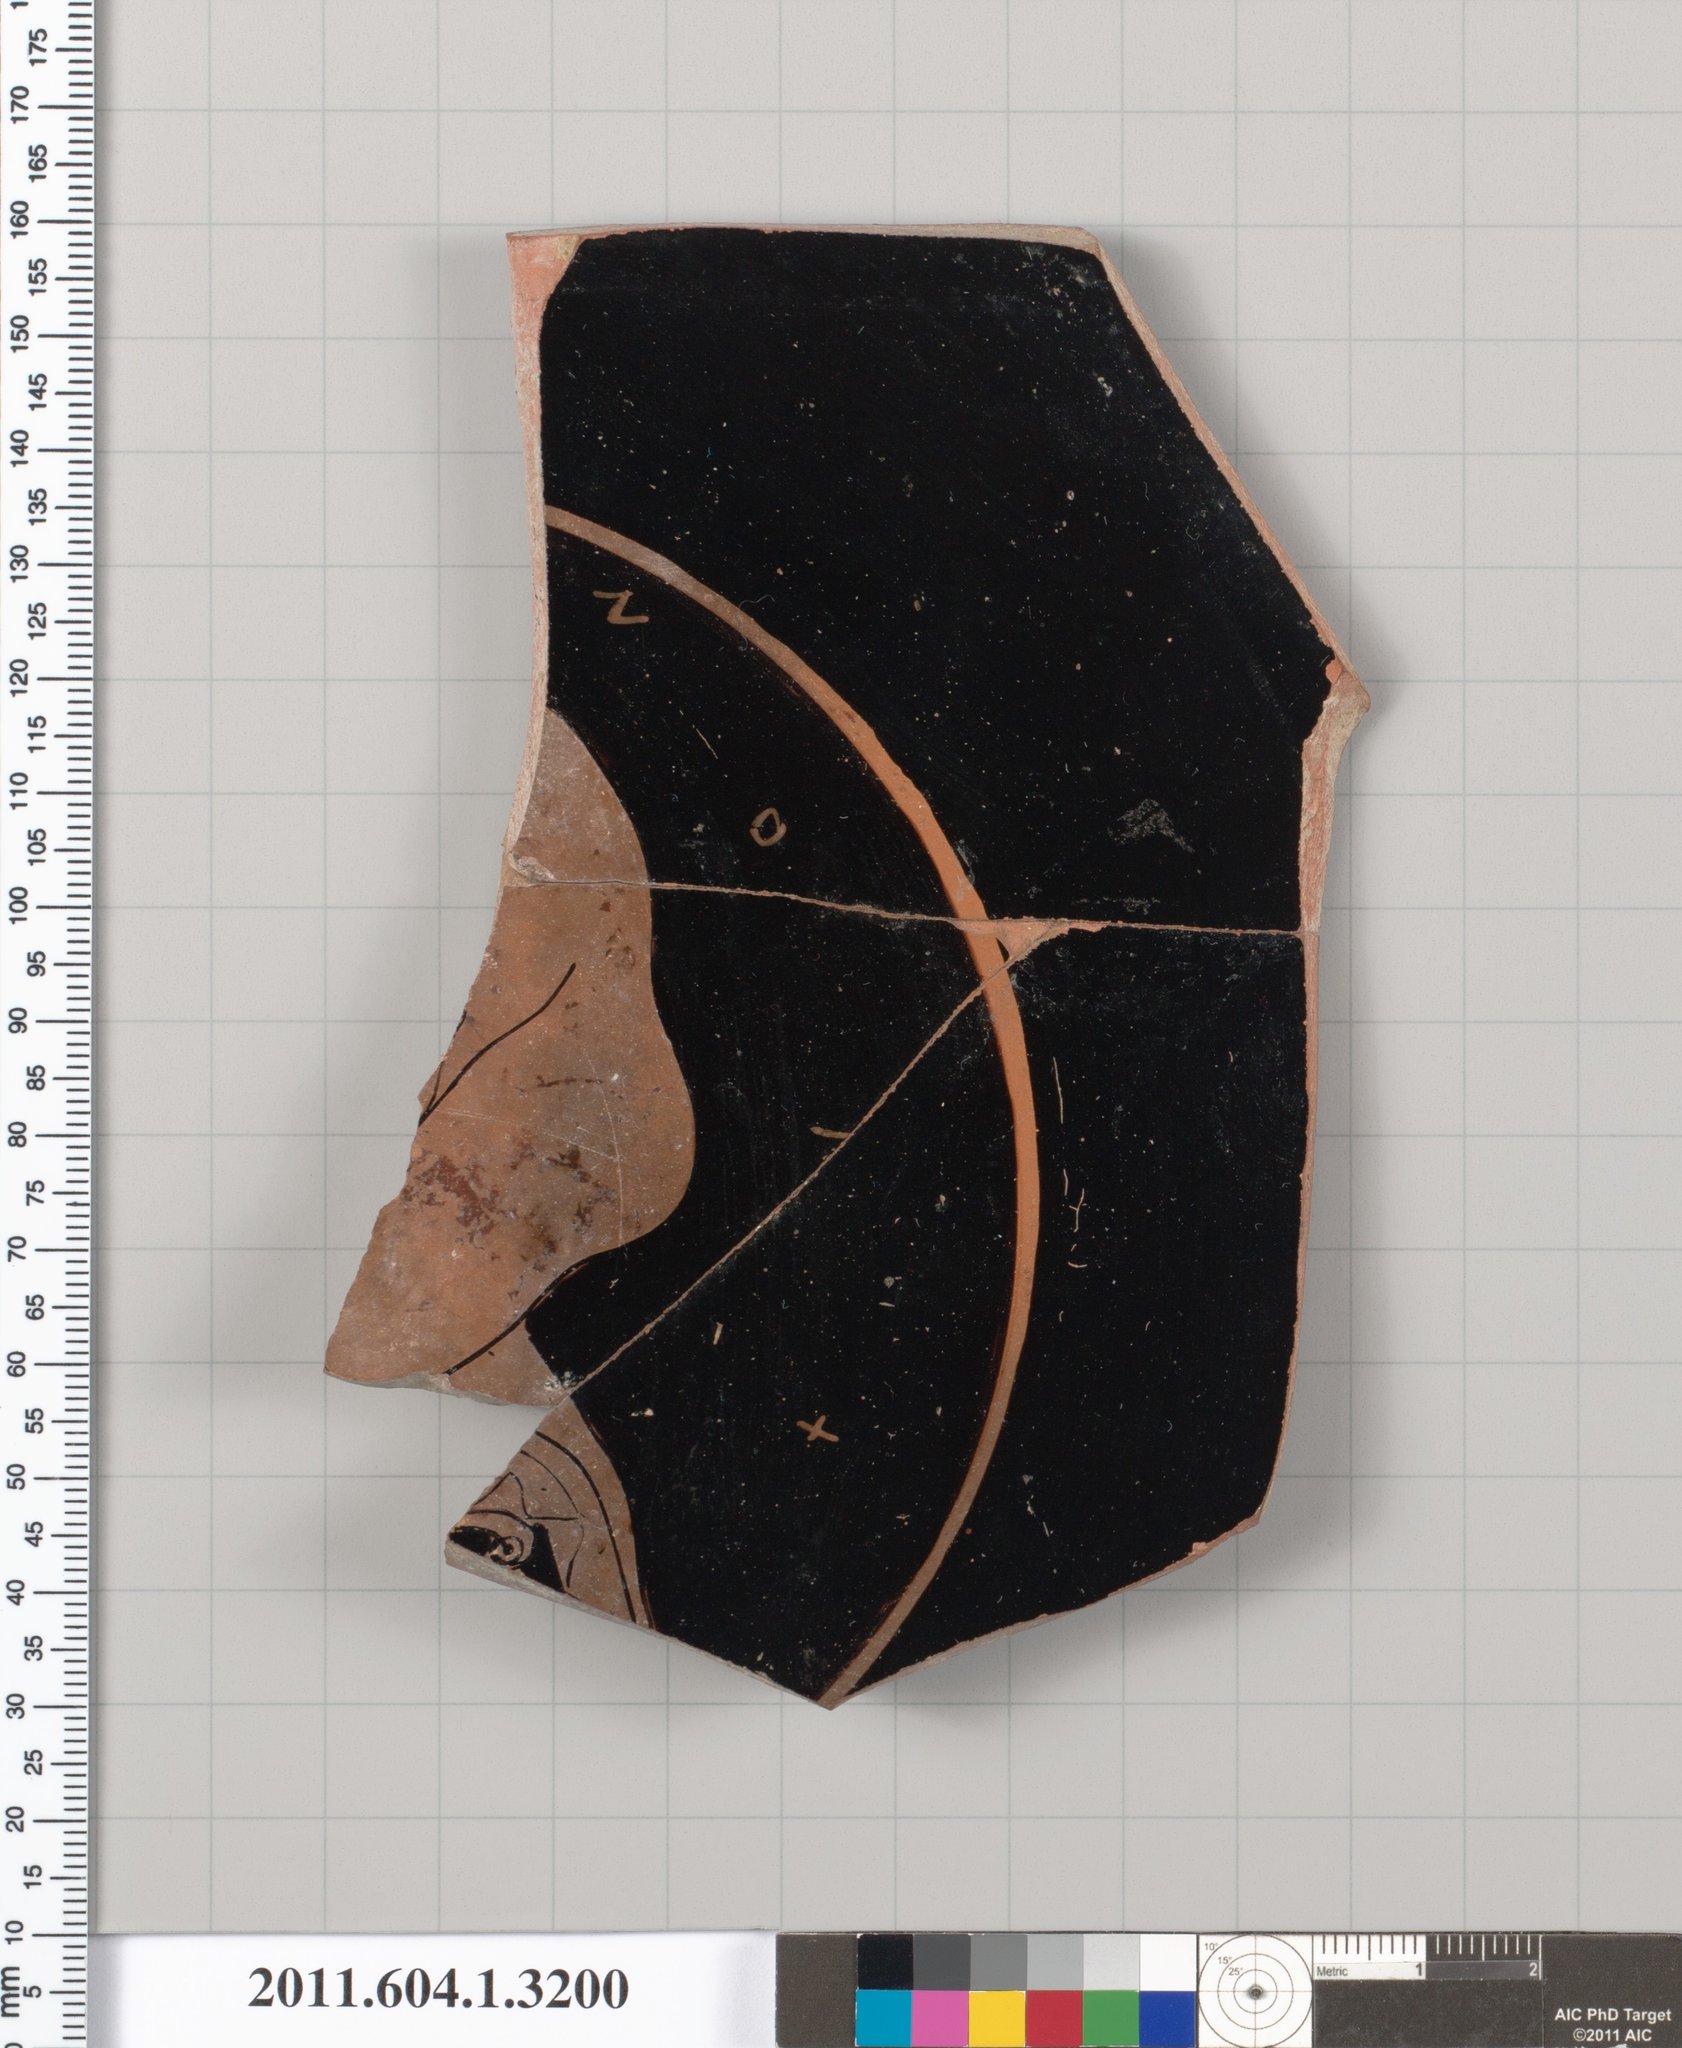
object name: kylix fragment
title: Terracotta fragment of a kylix (drinking cup)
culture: greek, attic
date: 520-500 BCE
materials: terracotta